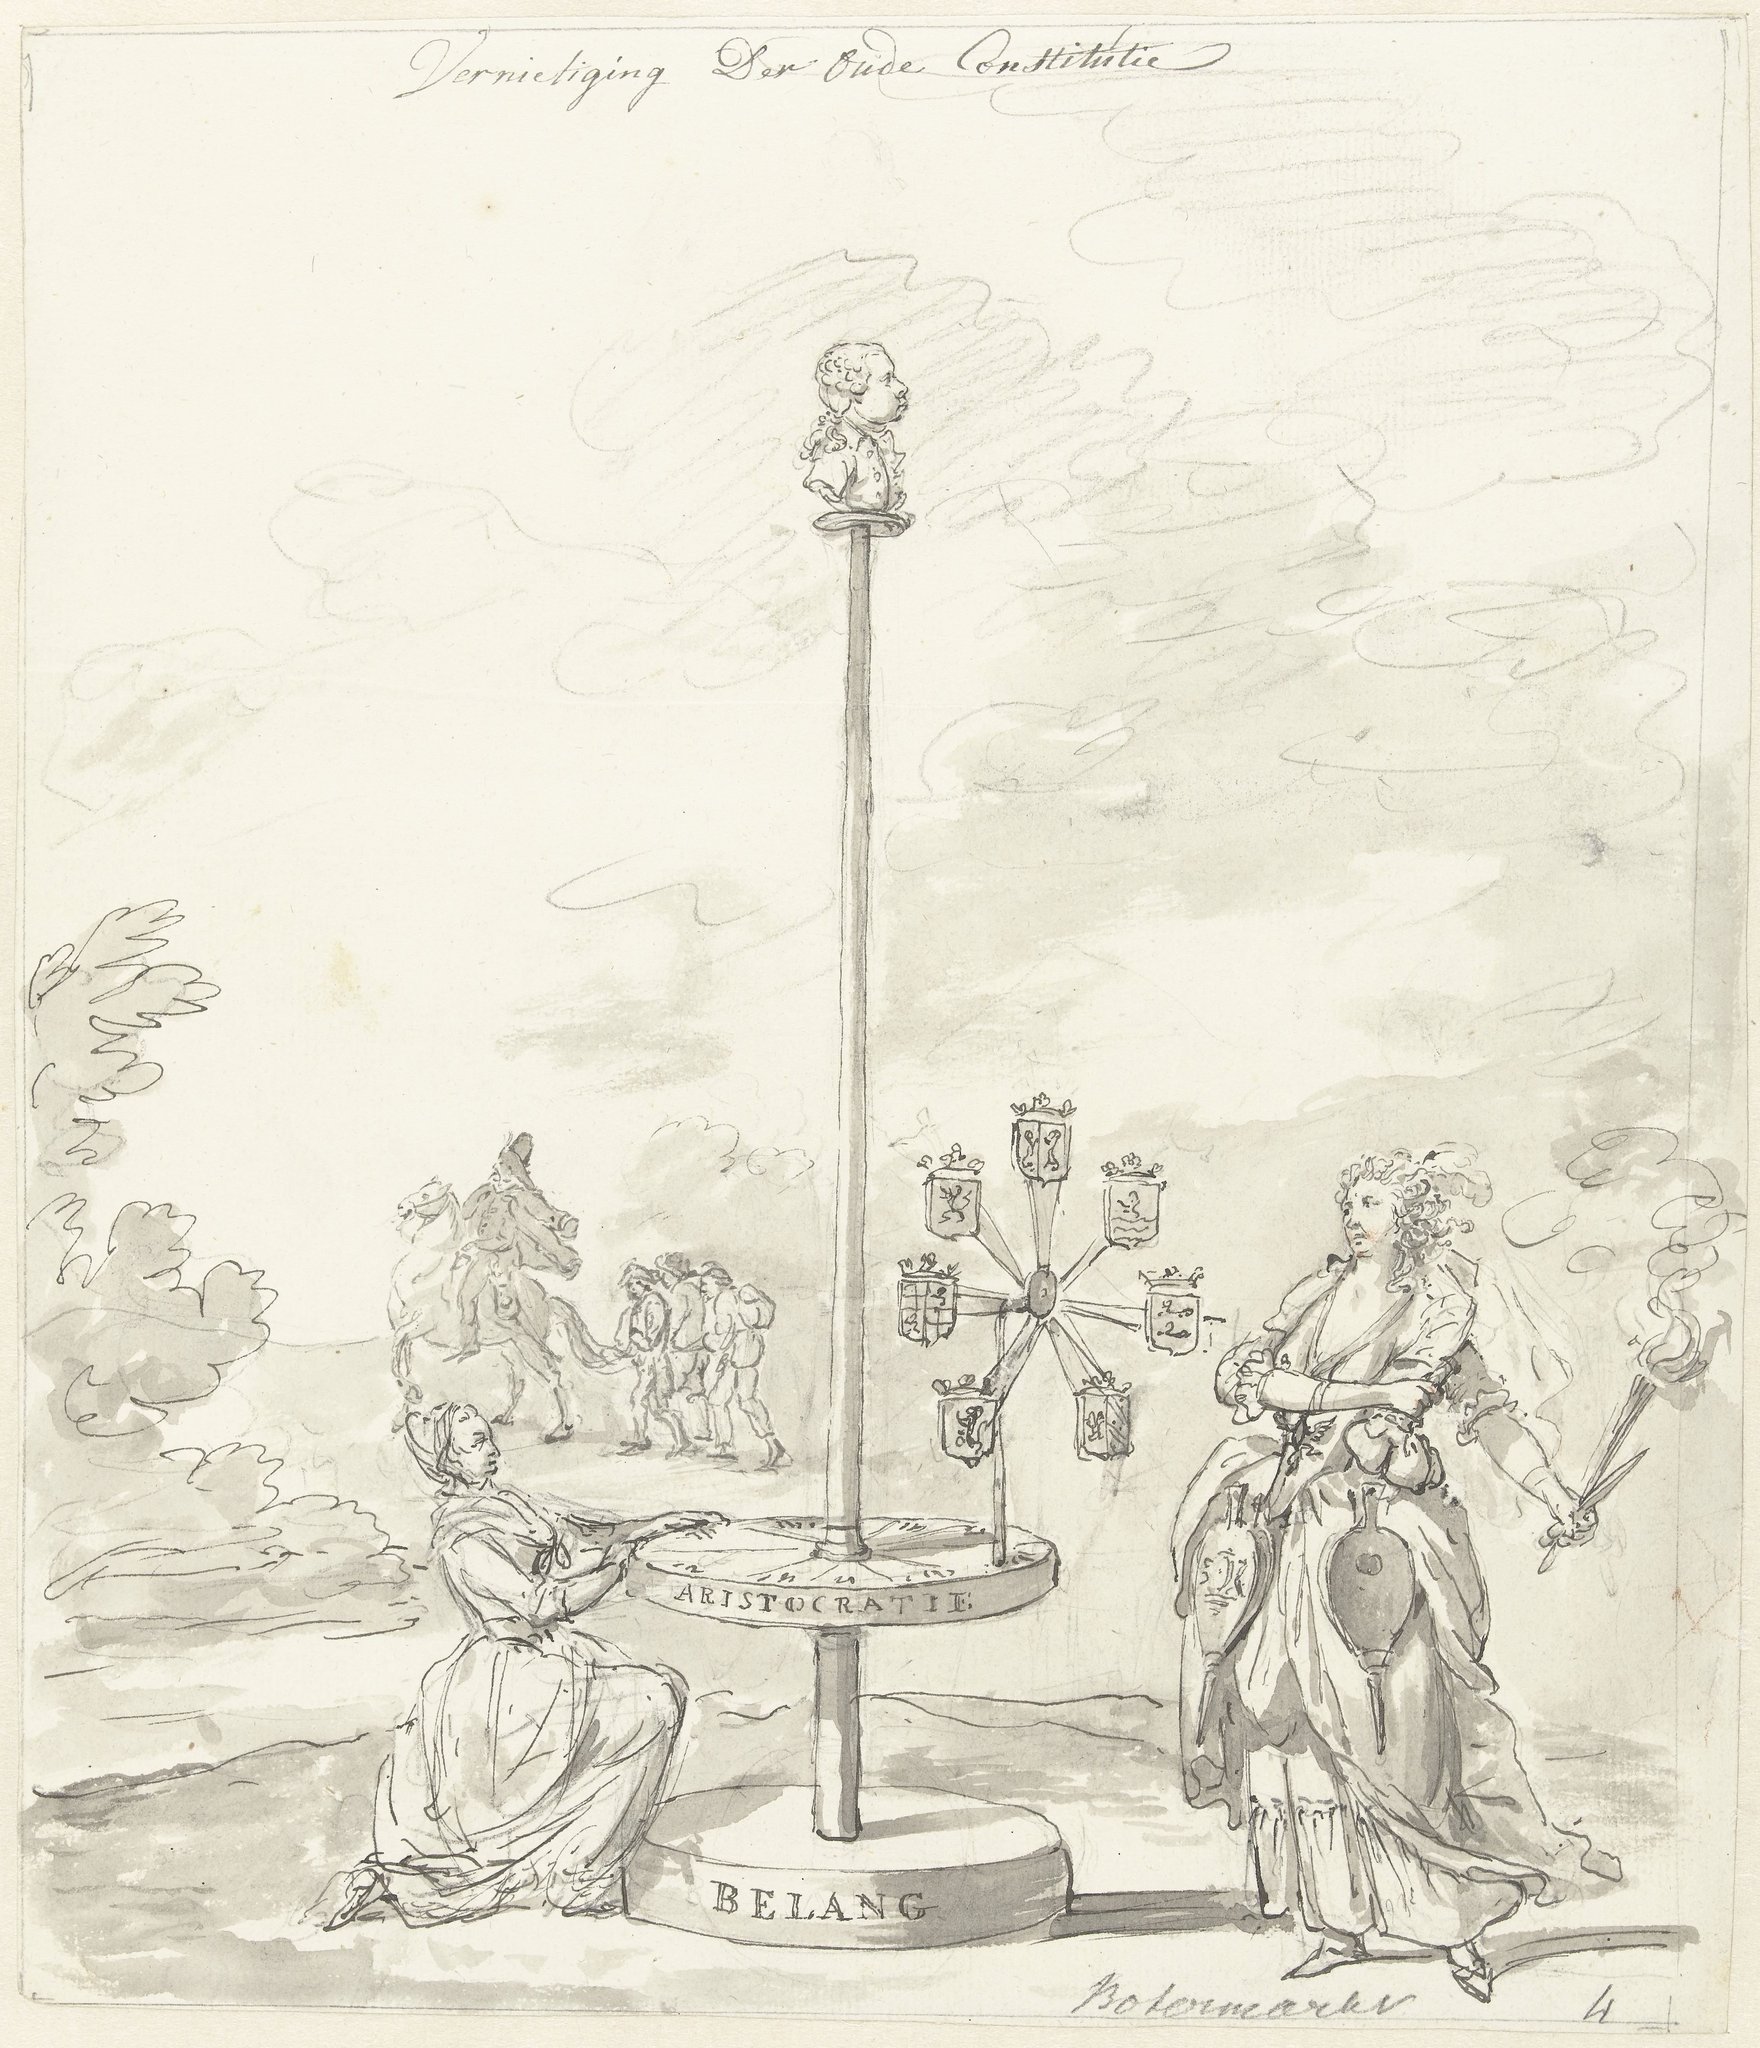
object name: design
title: Vernietiging Der Oude Constitutie/ Botermarkt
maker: Anonymous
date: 1795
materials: chalk, ink, paper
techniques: brush, pen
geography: netherlands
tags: the hague, william v (prince of orange), the old government and its supporters (after revolution), envy; 'invidia' (ripa) ~ personification of one of the seven deadly sins, political caricatures and satires, festivities on events of national importance (+ festive decoration ~ festive activities), alliance, league, union, foedus, amsterdam, alliance with france (1795)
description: De Nijd staande met brandende toorts bij het rad van de Aristocratie. Bovenop een buste van prins Willem V. Op de achtergrond vluchtende burgers. Niet gebruikt ontwerp voor de decoratie "Vernietiging der oude Constitutie" op de Botermarkt te Amsterdam bij het Alliantiefeest op 19 juni 1795.